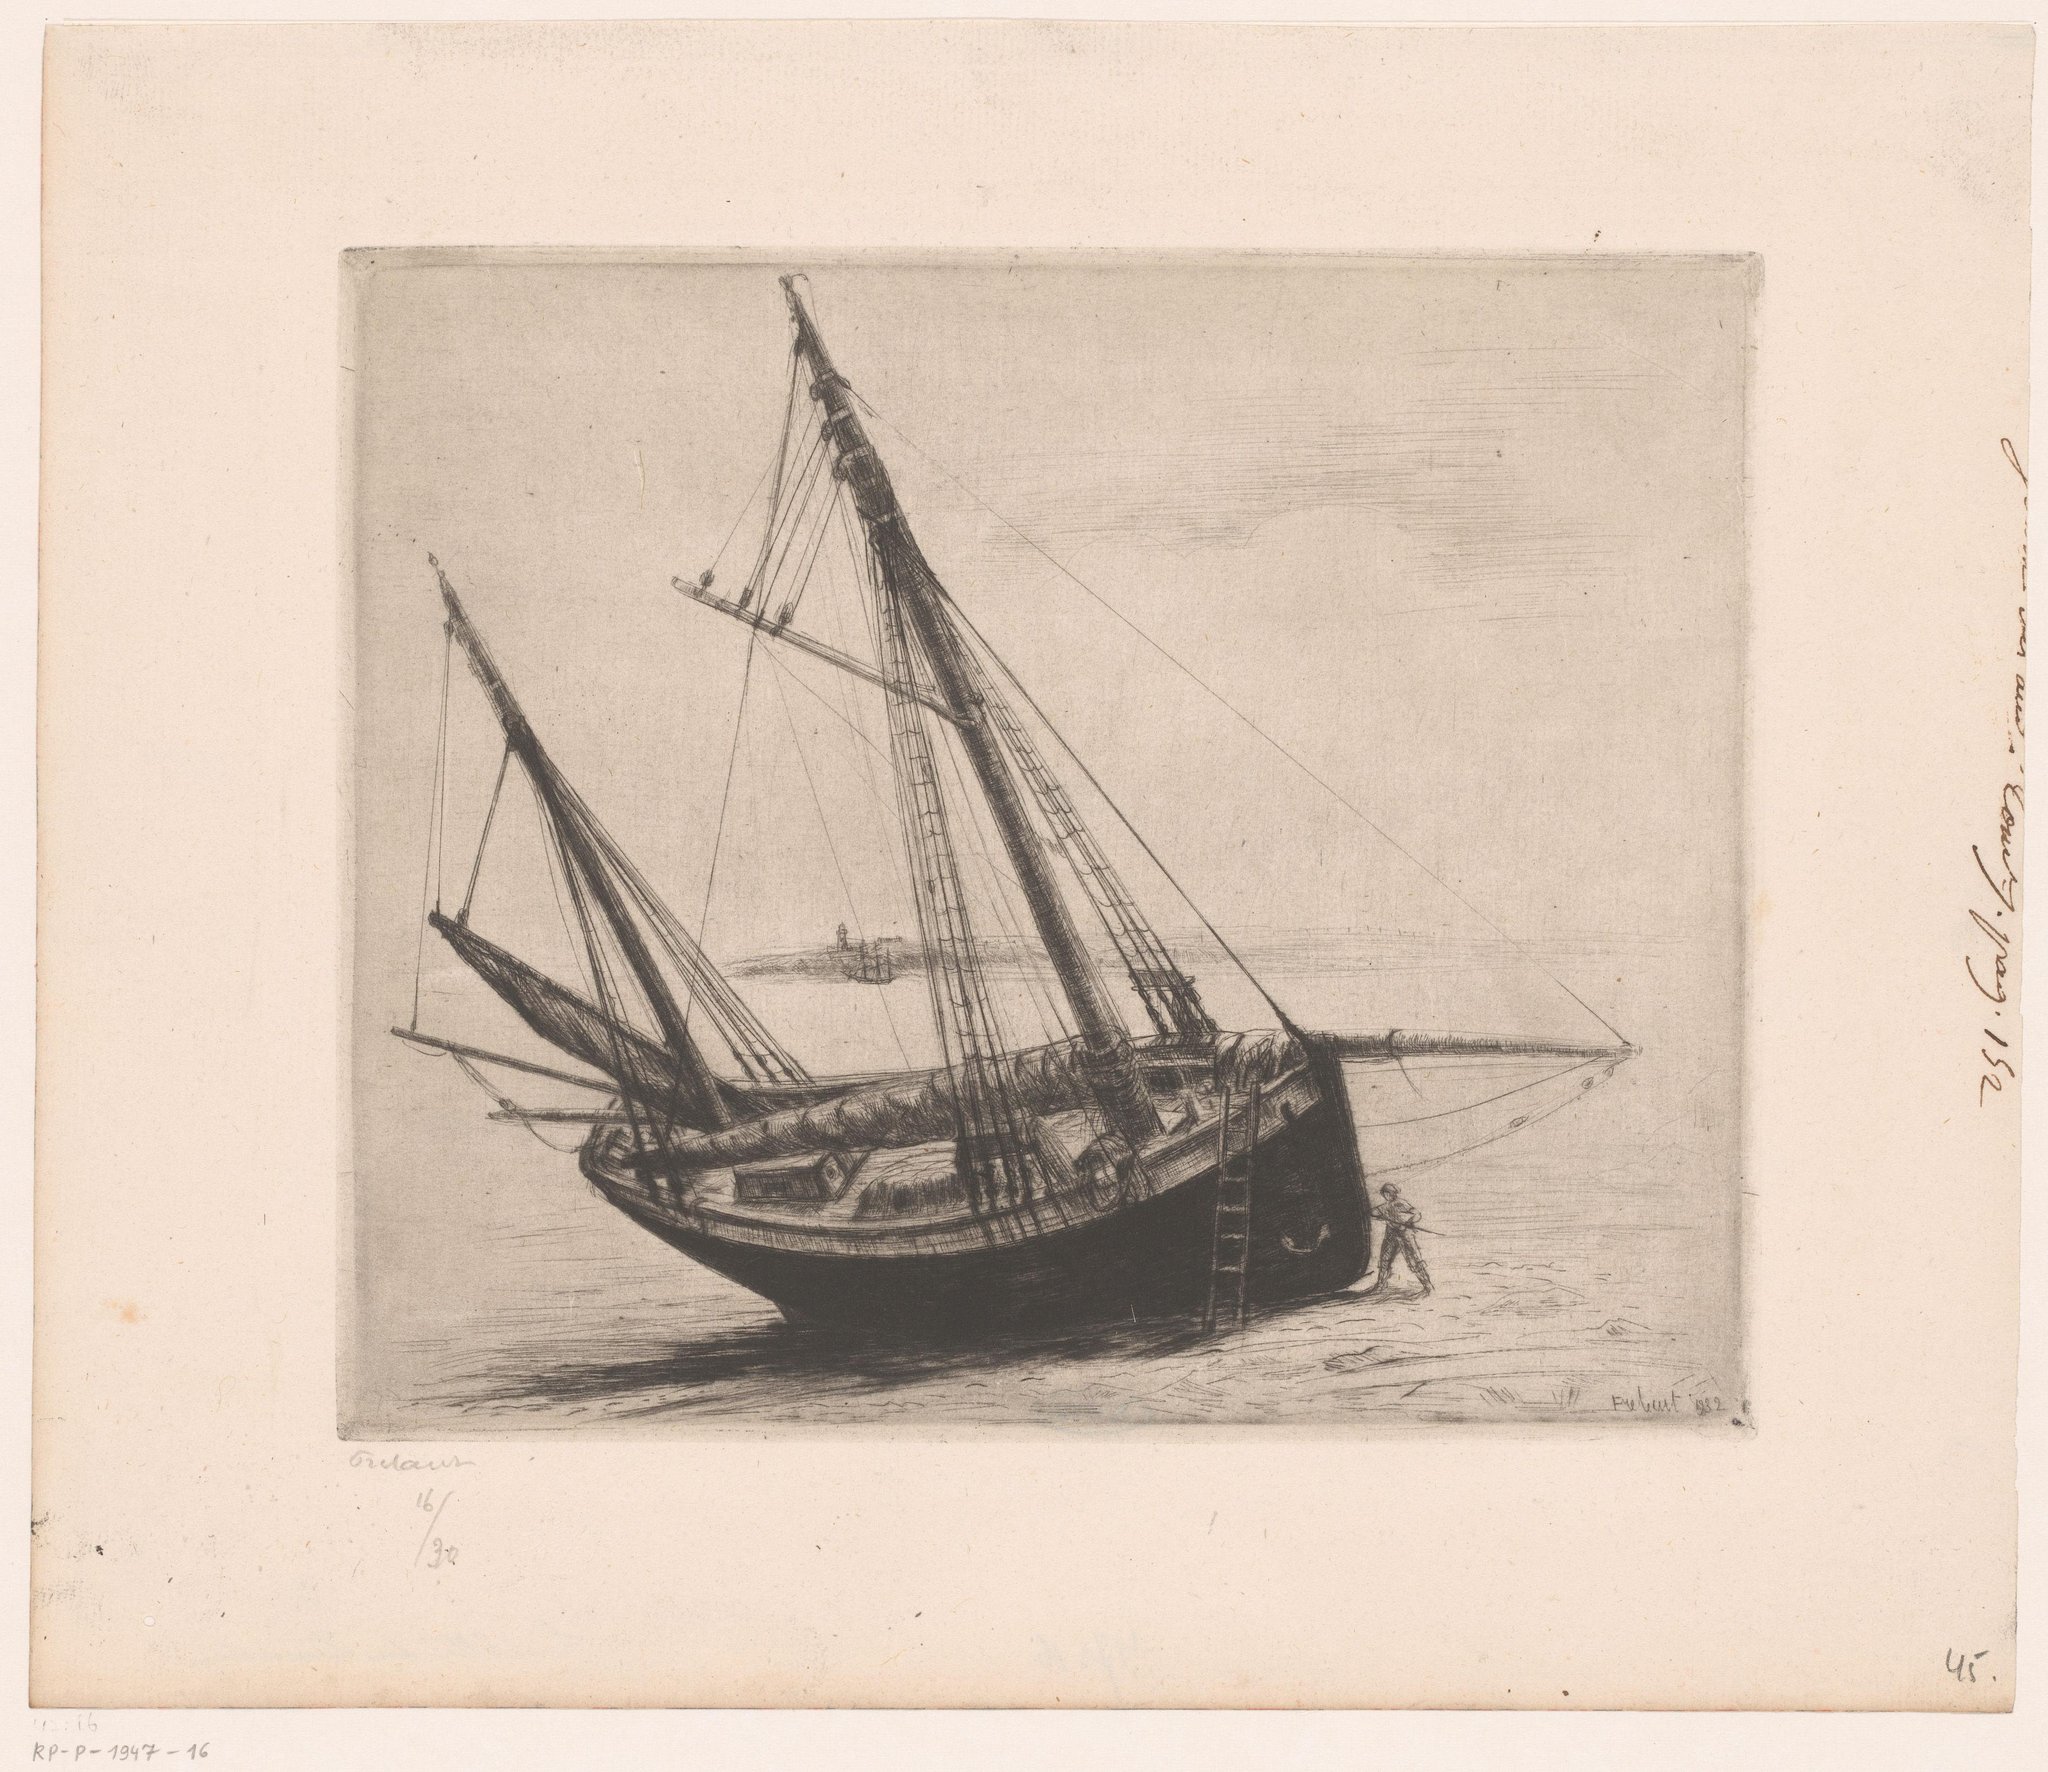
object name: print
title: Schip aangemeerd op het strand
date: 1932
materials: paper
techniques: drypoint, etching, intaglio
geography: paris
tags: ships (in general), beach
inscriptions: check stamp: Lugt 2254, collector's mark: Lugt 2228, inscription: ‘[...] pag. 152’